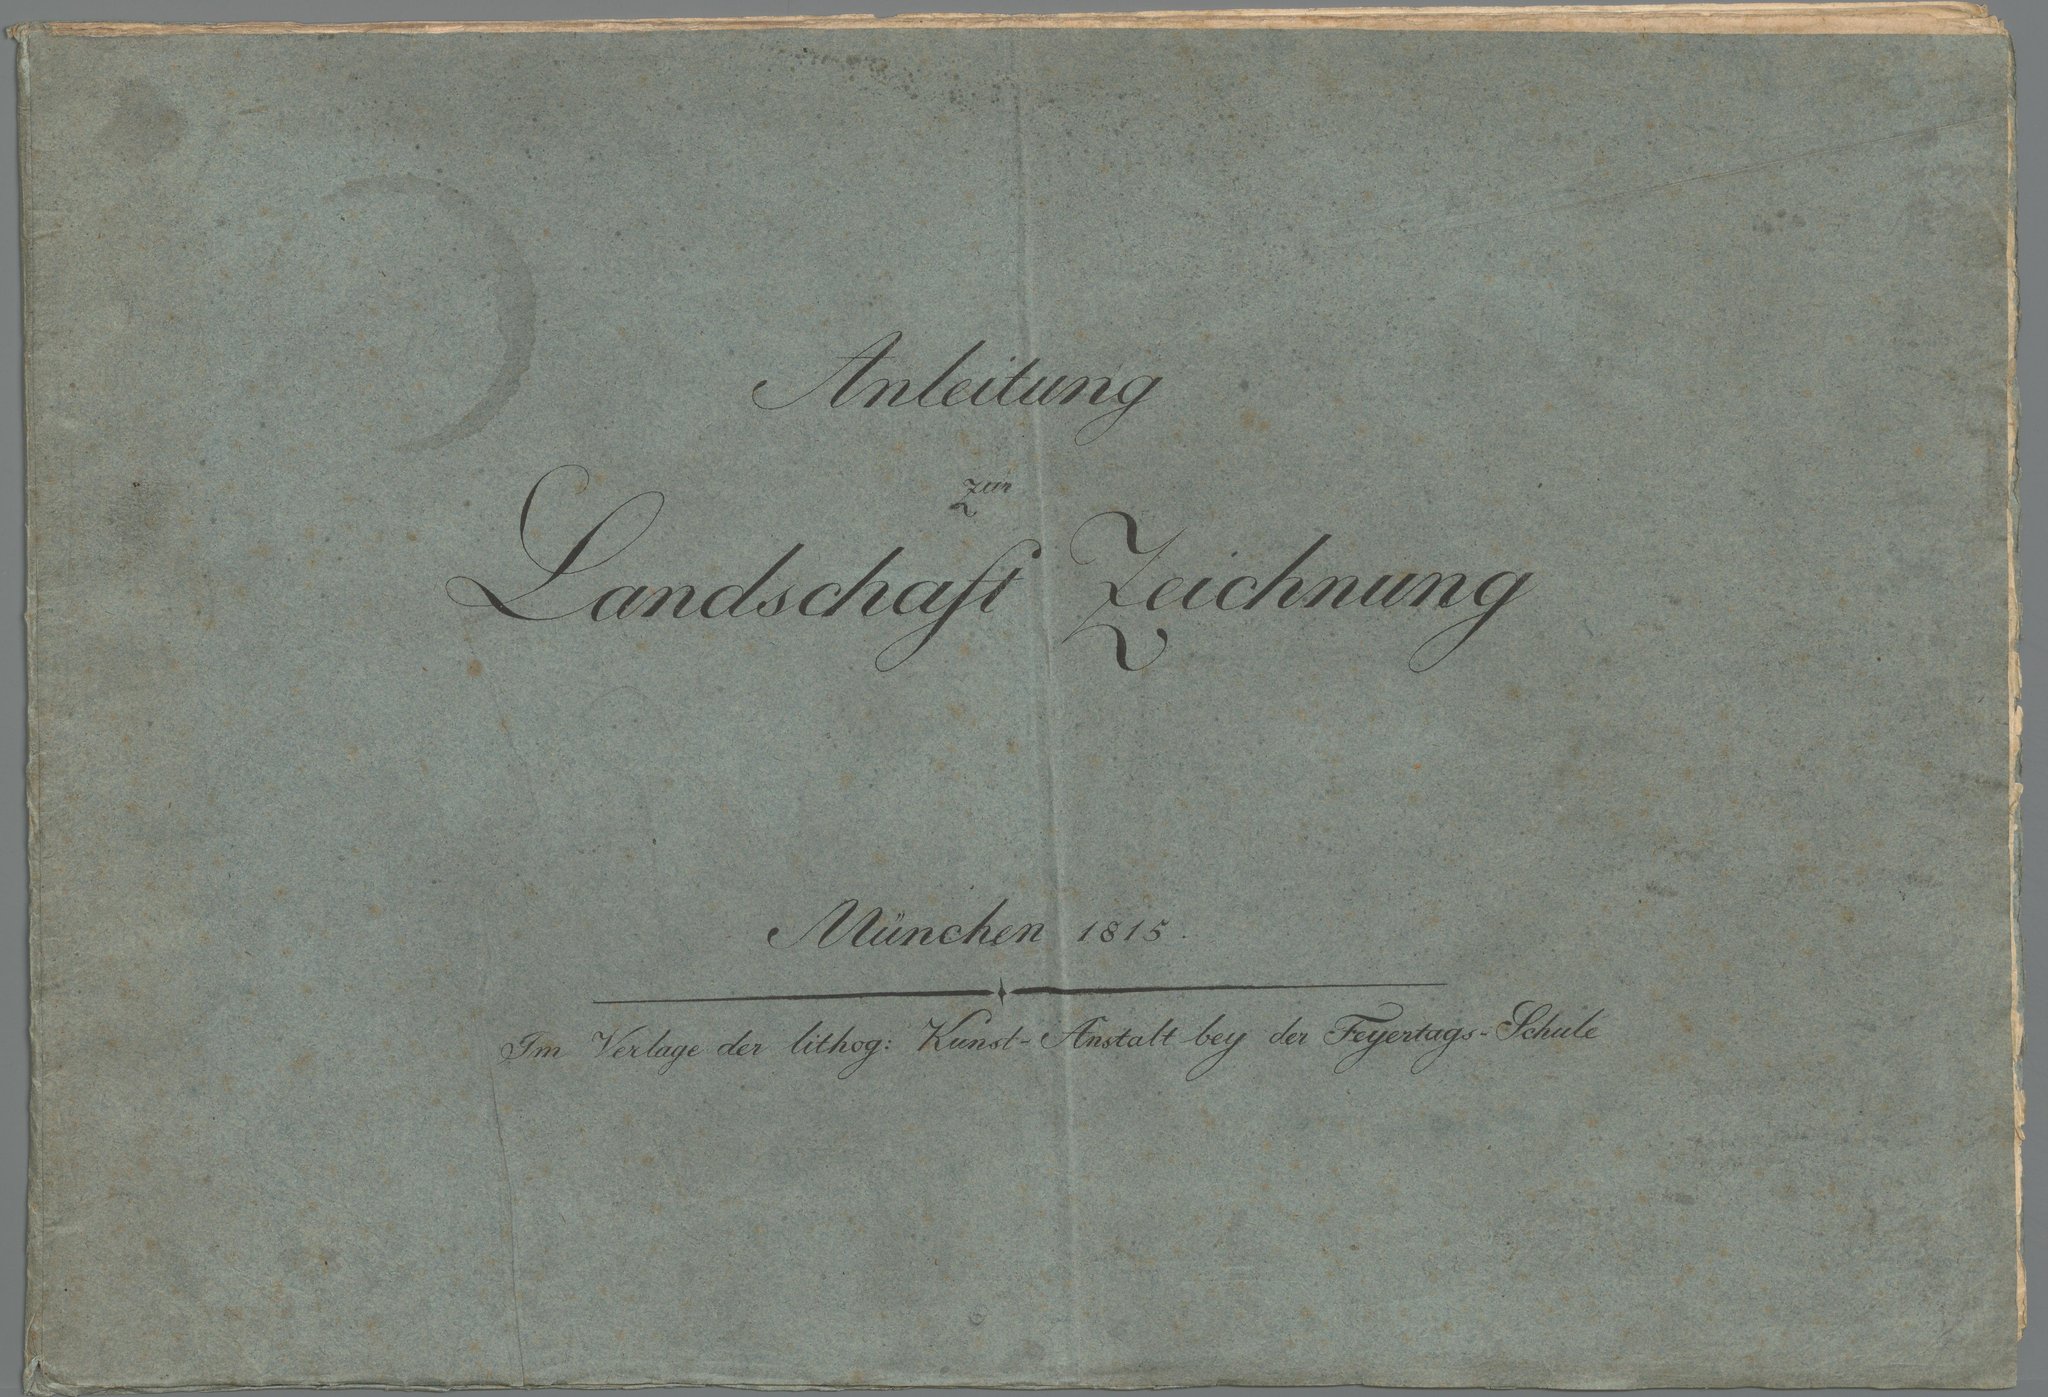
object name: album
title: Anleitung zur Landschaft-Zeichnung in Handzeignungs Manier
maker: max josef wagenbauer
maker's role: print maker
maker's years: 1774-1829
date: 1816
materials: paper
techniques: lithograph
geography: munich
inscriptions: collector's mark: Lugt 2760, collector's mark: Lugt 2228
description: Album met voorstellingen van bomen, gebouwen en landschappen. 36 steendrukken op 18 bladen. Omslag van blauw papier.